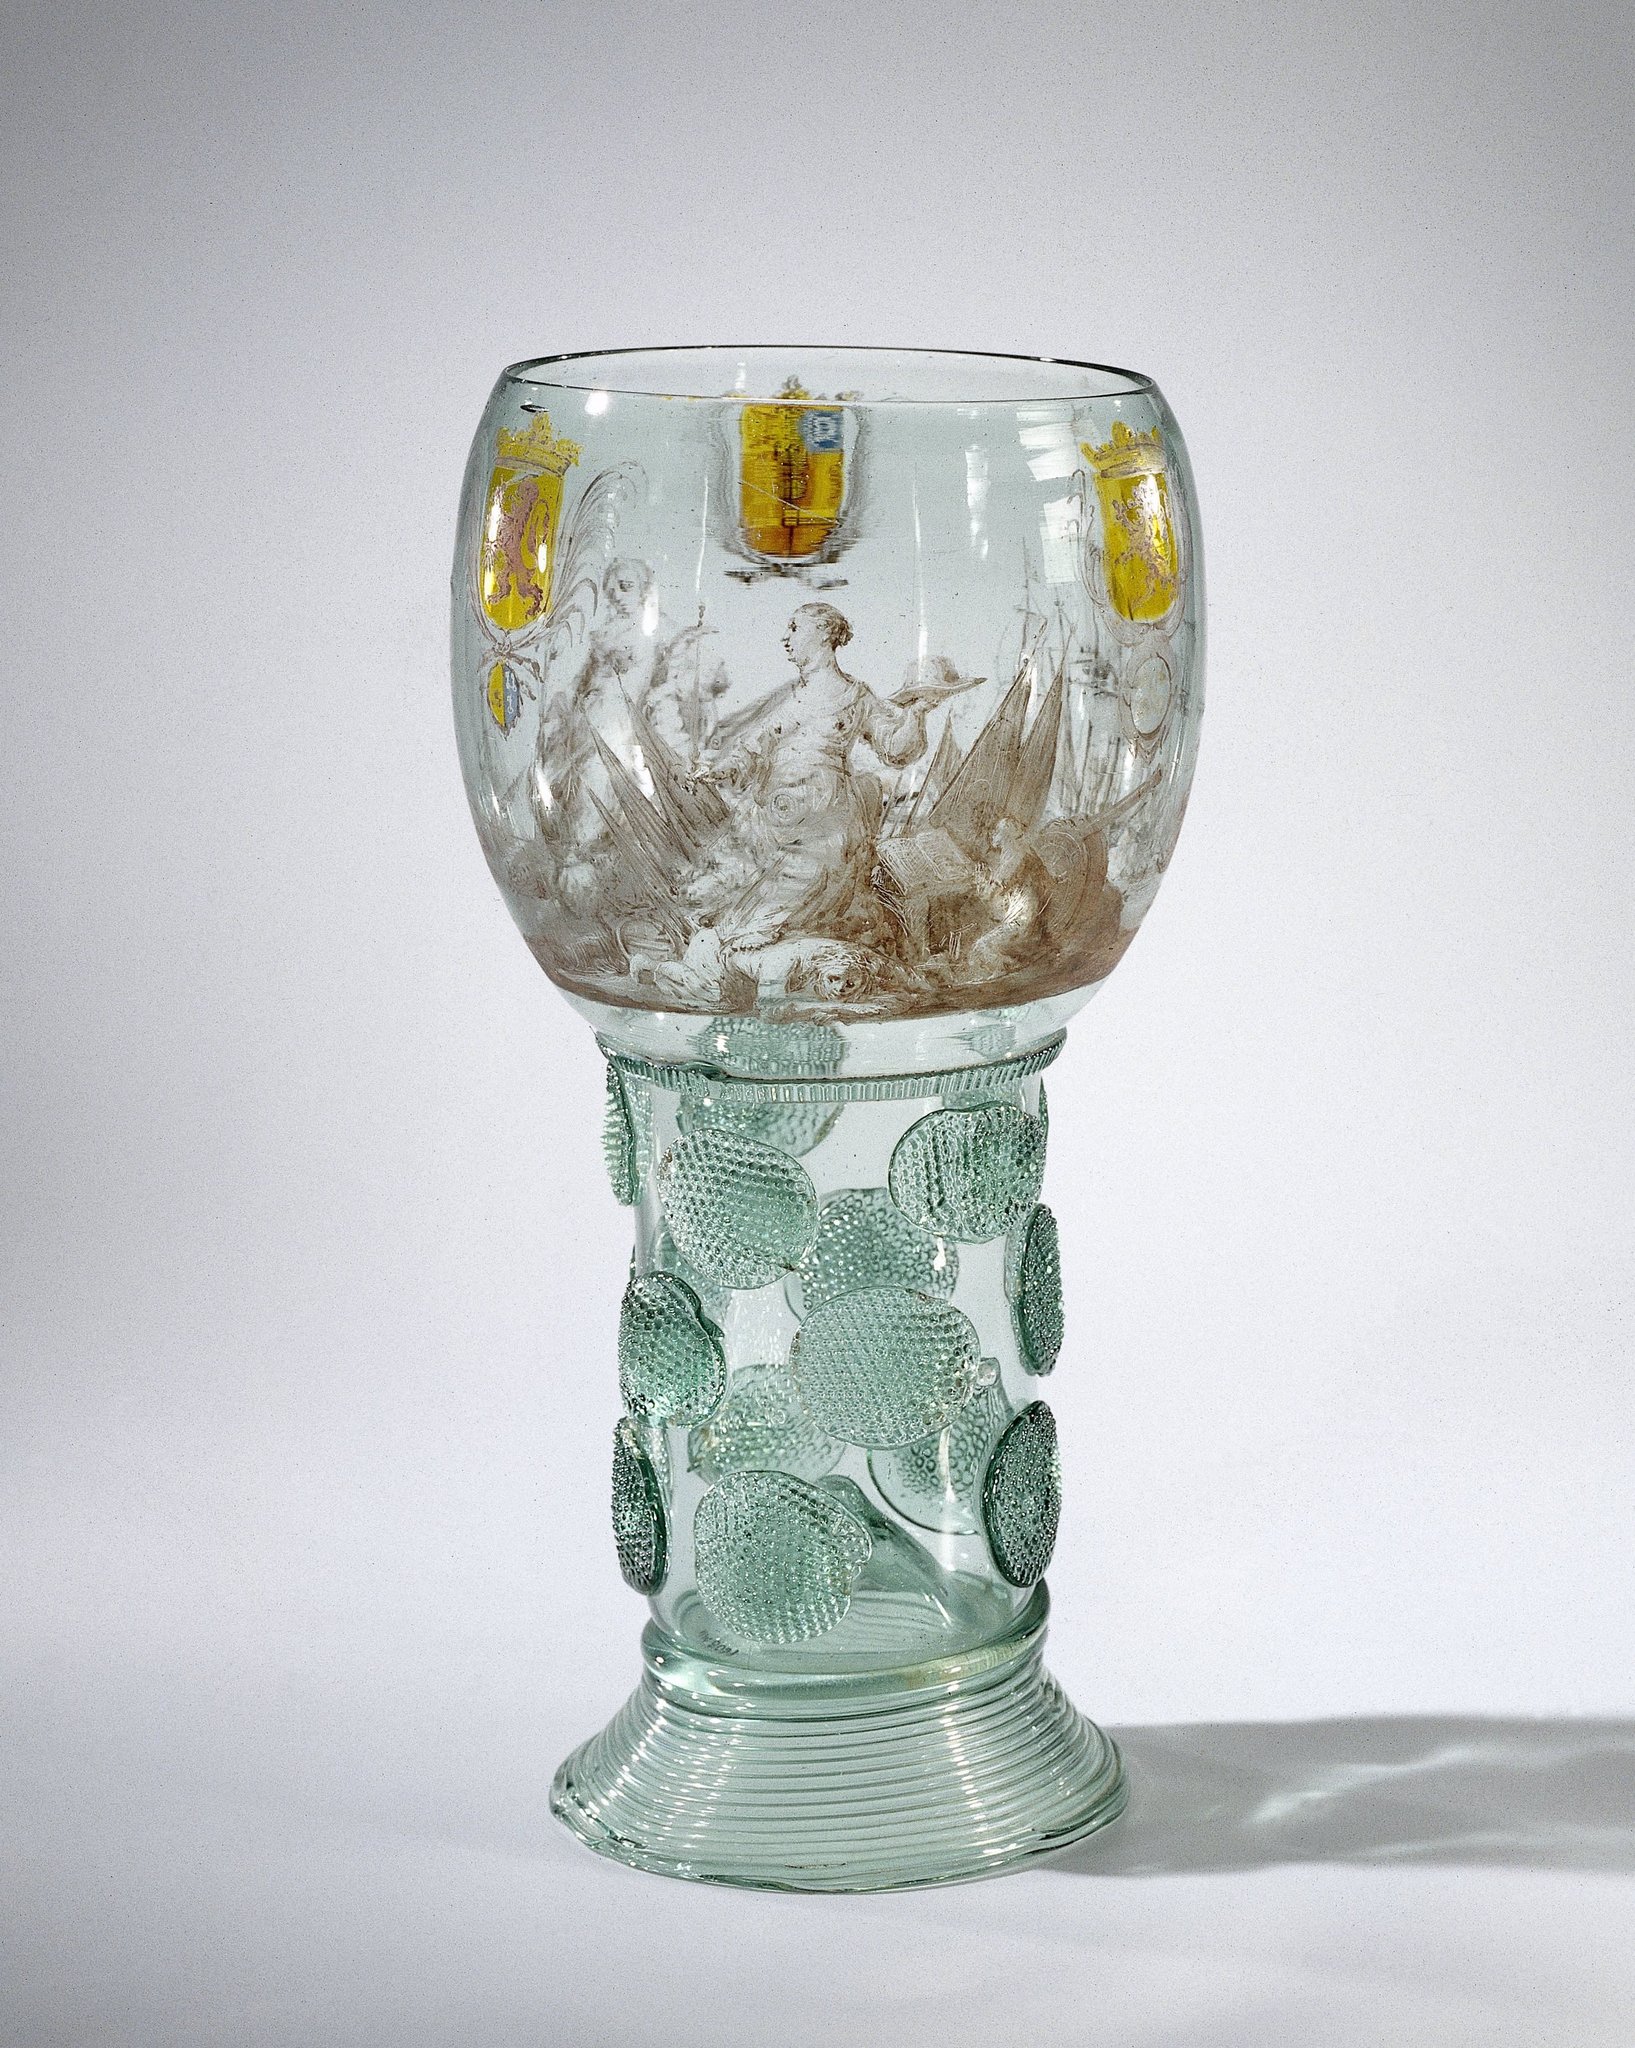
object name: roemer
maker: Anonymous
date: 1675-1700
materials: glass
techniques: glassblowing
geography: northern netherlands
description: The two loosely painted women symbolize Peace and Freedom. Peace is depicted with an olive branch and a large horn of plenty, Freedom with sceptre and hat in hand. The specific event this glass refers to is not clear. It may relate to the Nijmegen Peace Treaties (1678/79), which marked the end of the Dutch War with France.